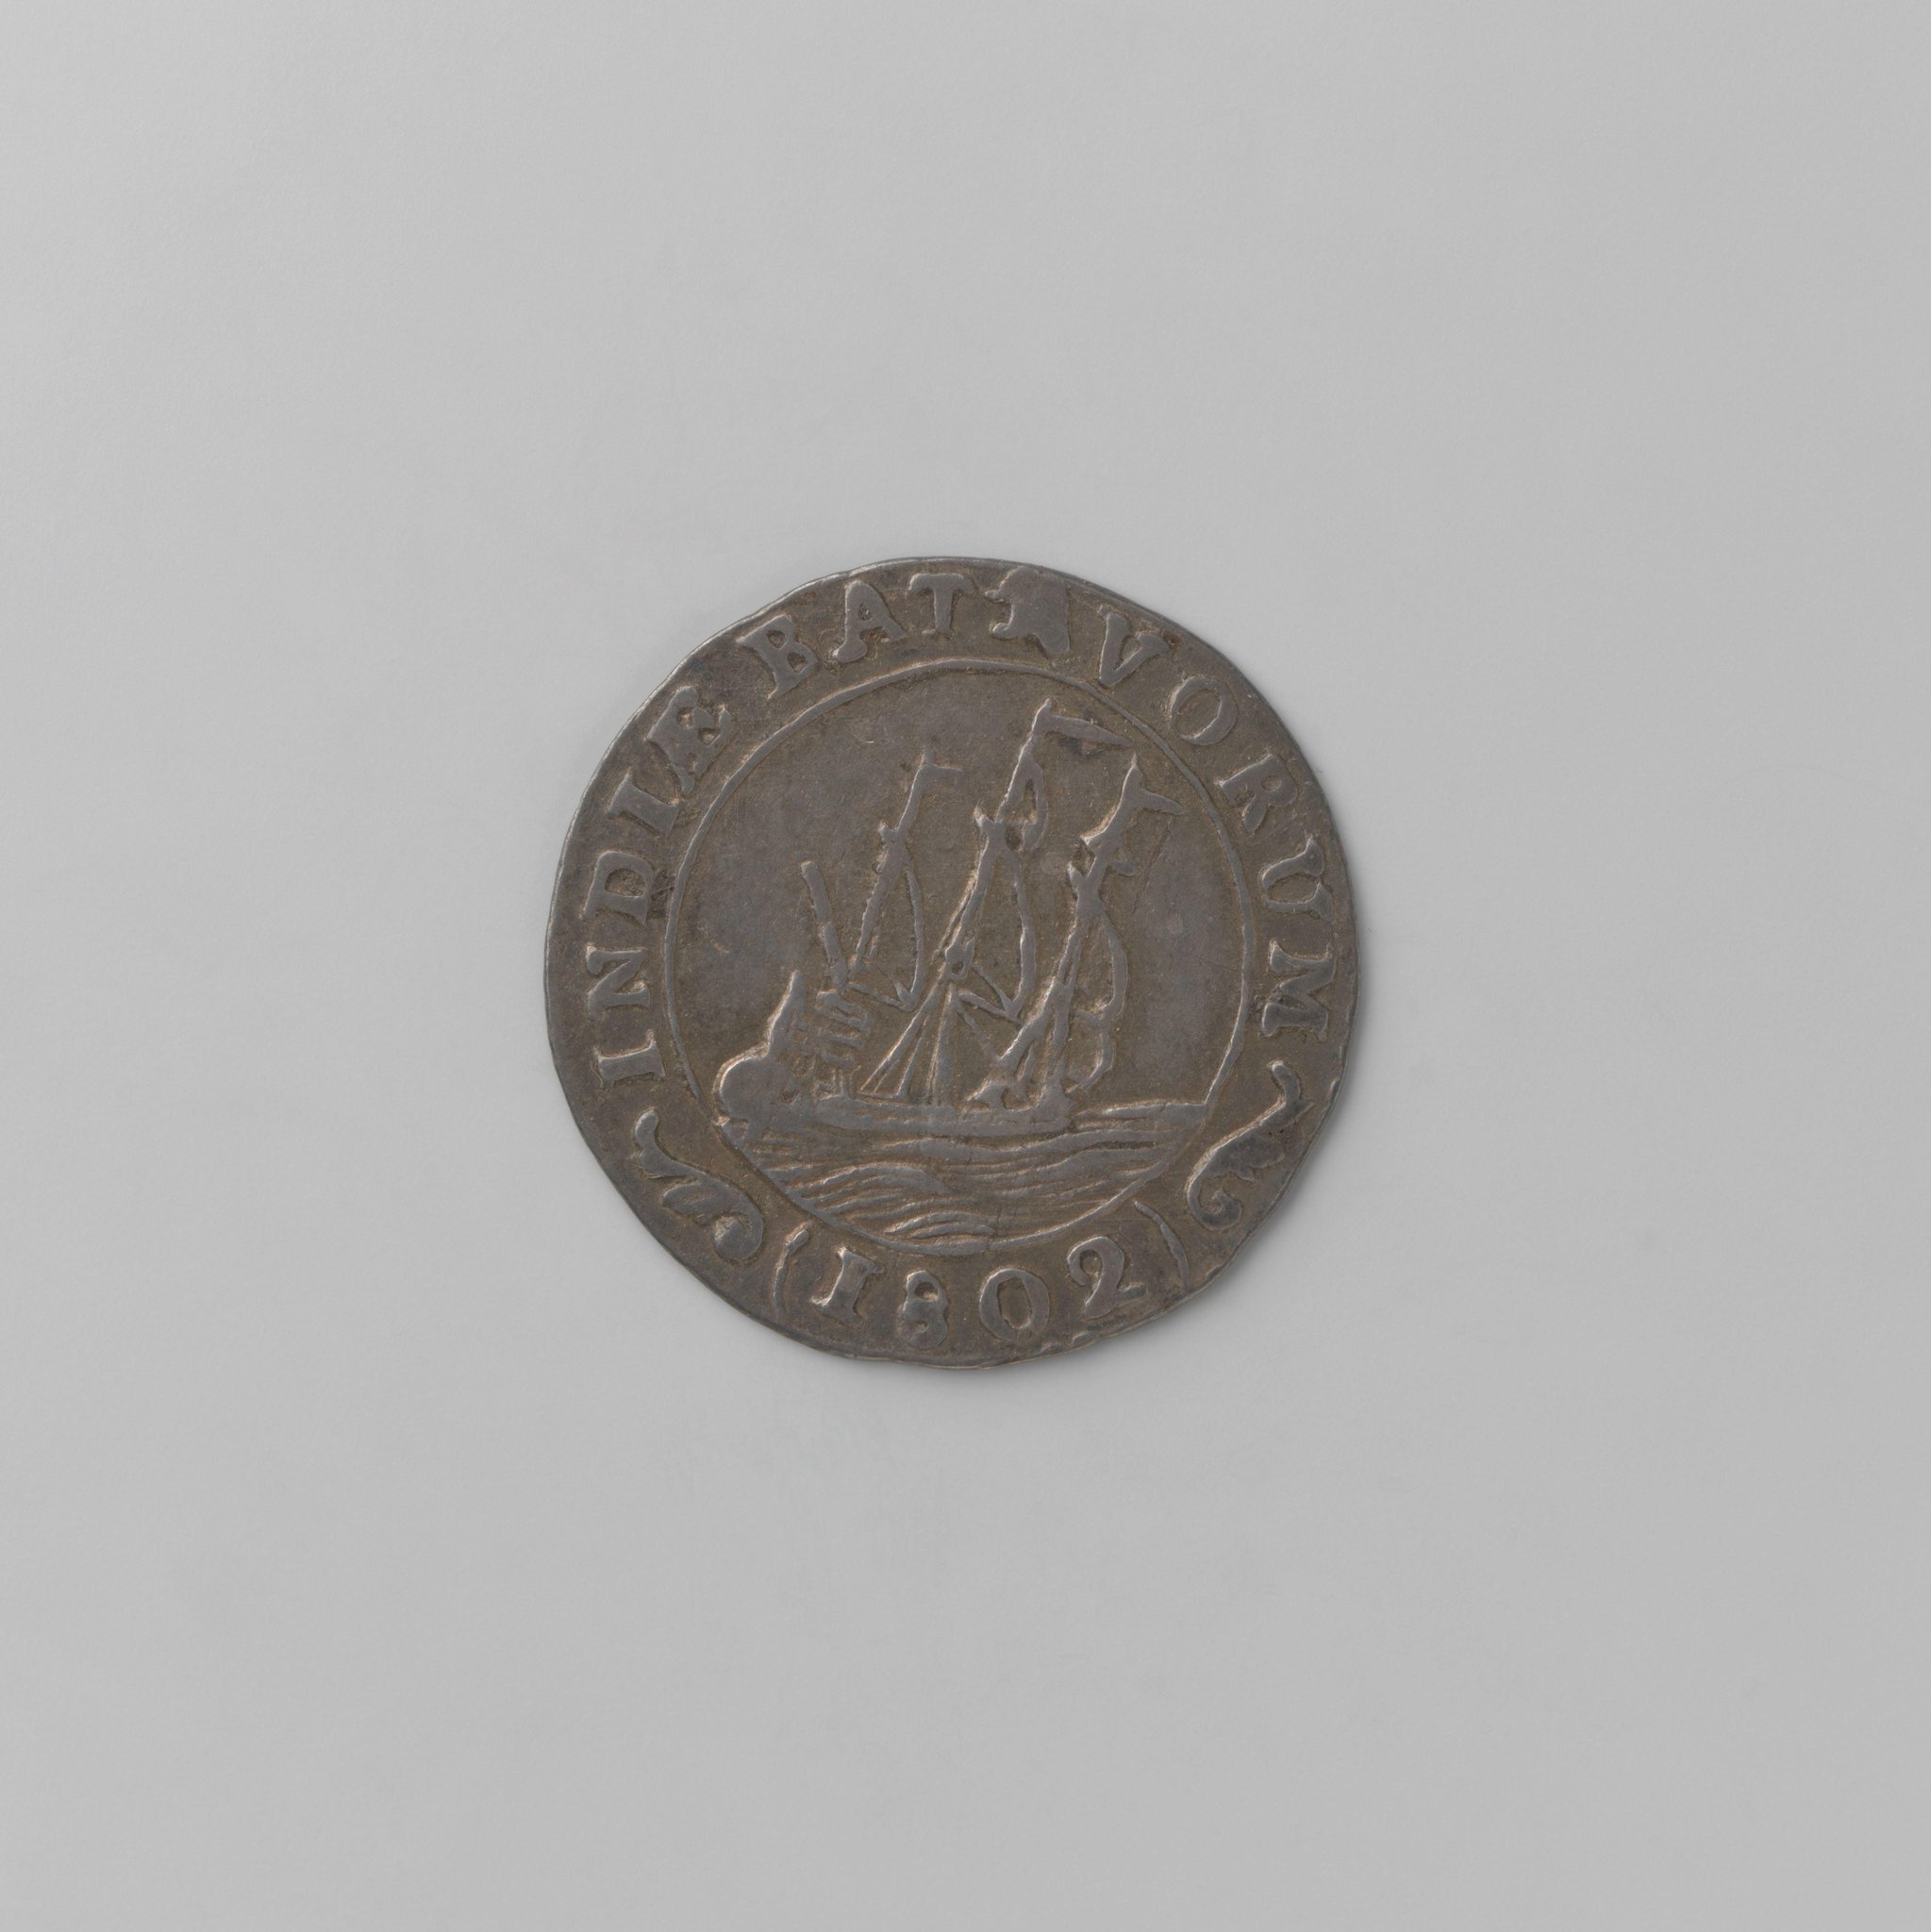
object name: coin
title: 1/16 scheepjesgulden, 1802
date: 1802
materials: silver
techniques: striking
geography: enkhuizen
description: Zilveren munt. Voorzijde: binnen cirkel driemaster met volle zeilen op open zee. Versierd jaartal onderaan in omschrift. Keerzijde: tussen waarde-aanduiding 1/16 G gekroond generaliteitswapenschild. Muntteken boven kroon in omschrift. Gladde rand.